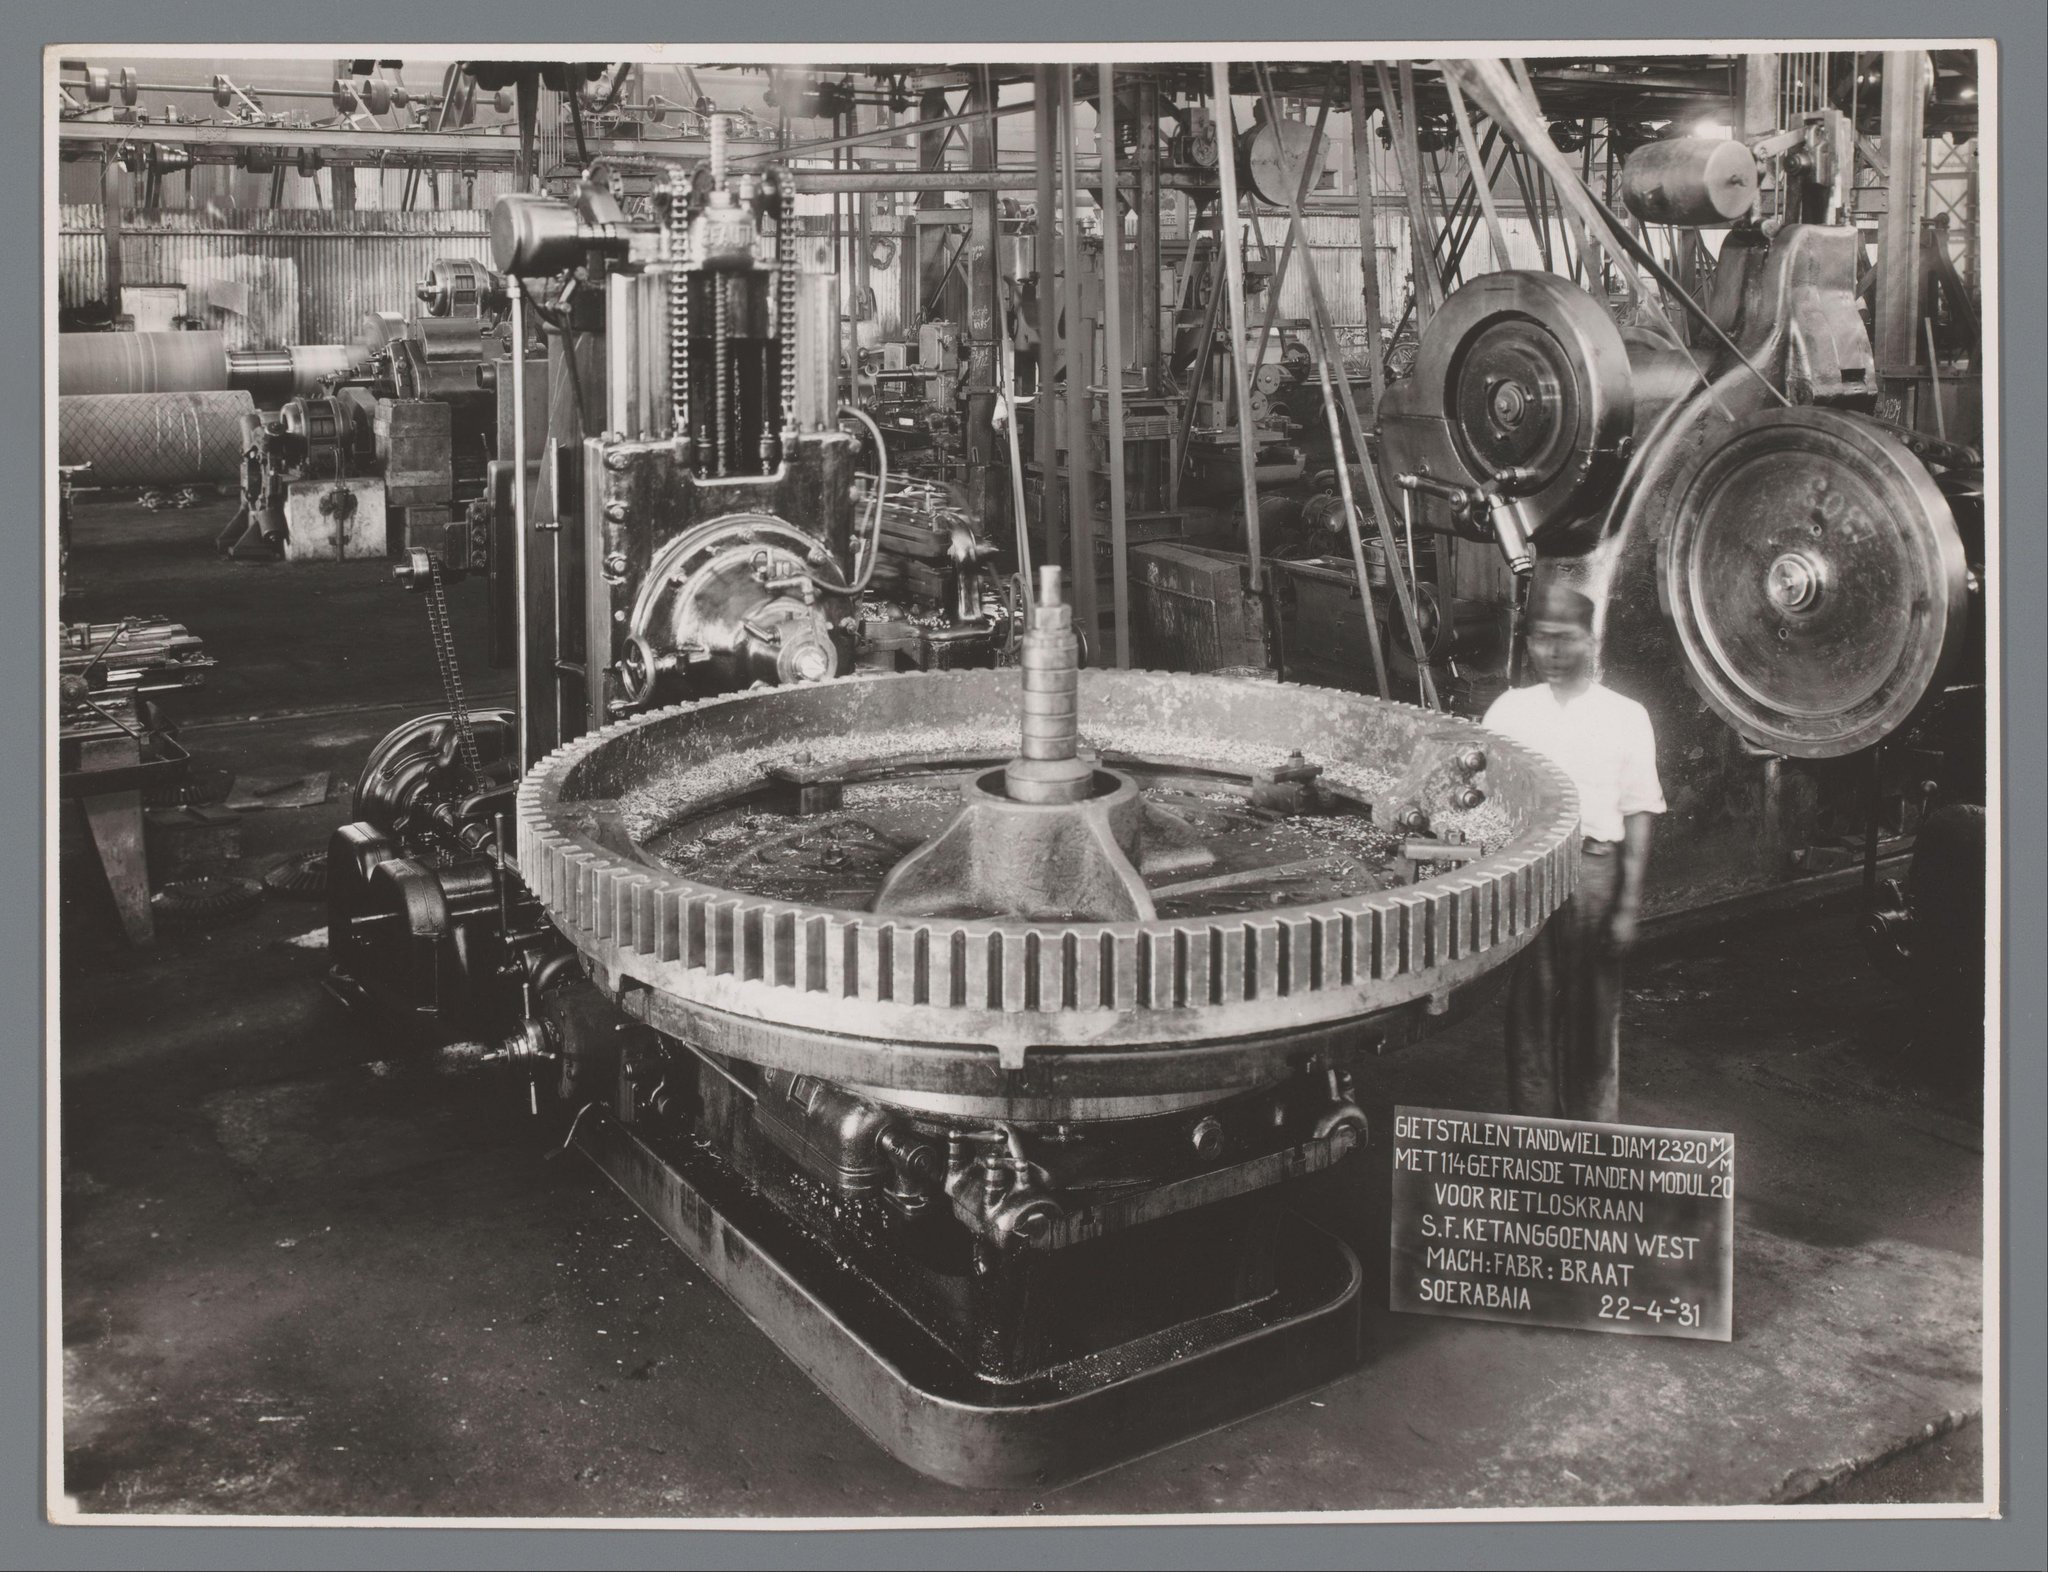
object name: photograph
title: Tandwiel voor rietloskraan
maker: Anonymous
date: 1931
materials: photographic support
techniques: gelatin silver print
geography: surabaya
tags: colonial system, machines; parts of machines; tools and appliances, (non-fruit) products of plants or trees: sugarcane, interior of industrial structures (regardless of the materials processed or the products made, java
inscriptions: date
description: Gietstalen tandwiel voor een rietloskraan, vervaardigd in 1931 en bestemd voor de Suikerfabriek Ketanggoenan West. Onderdeel van de multomap met foto's van machines van de N.V. Machinefabriek Braat te Soerabaja bestemd voor de Nederlandse suikerindustrie op Java, uit de periode 1917-1938.